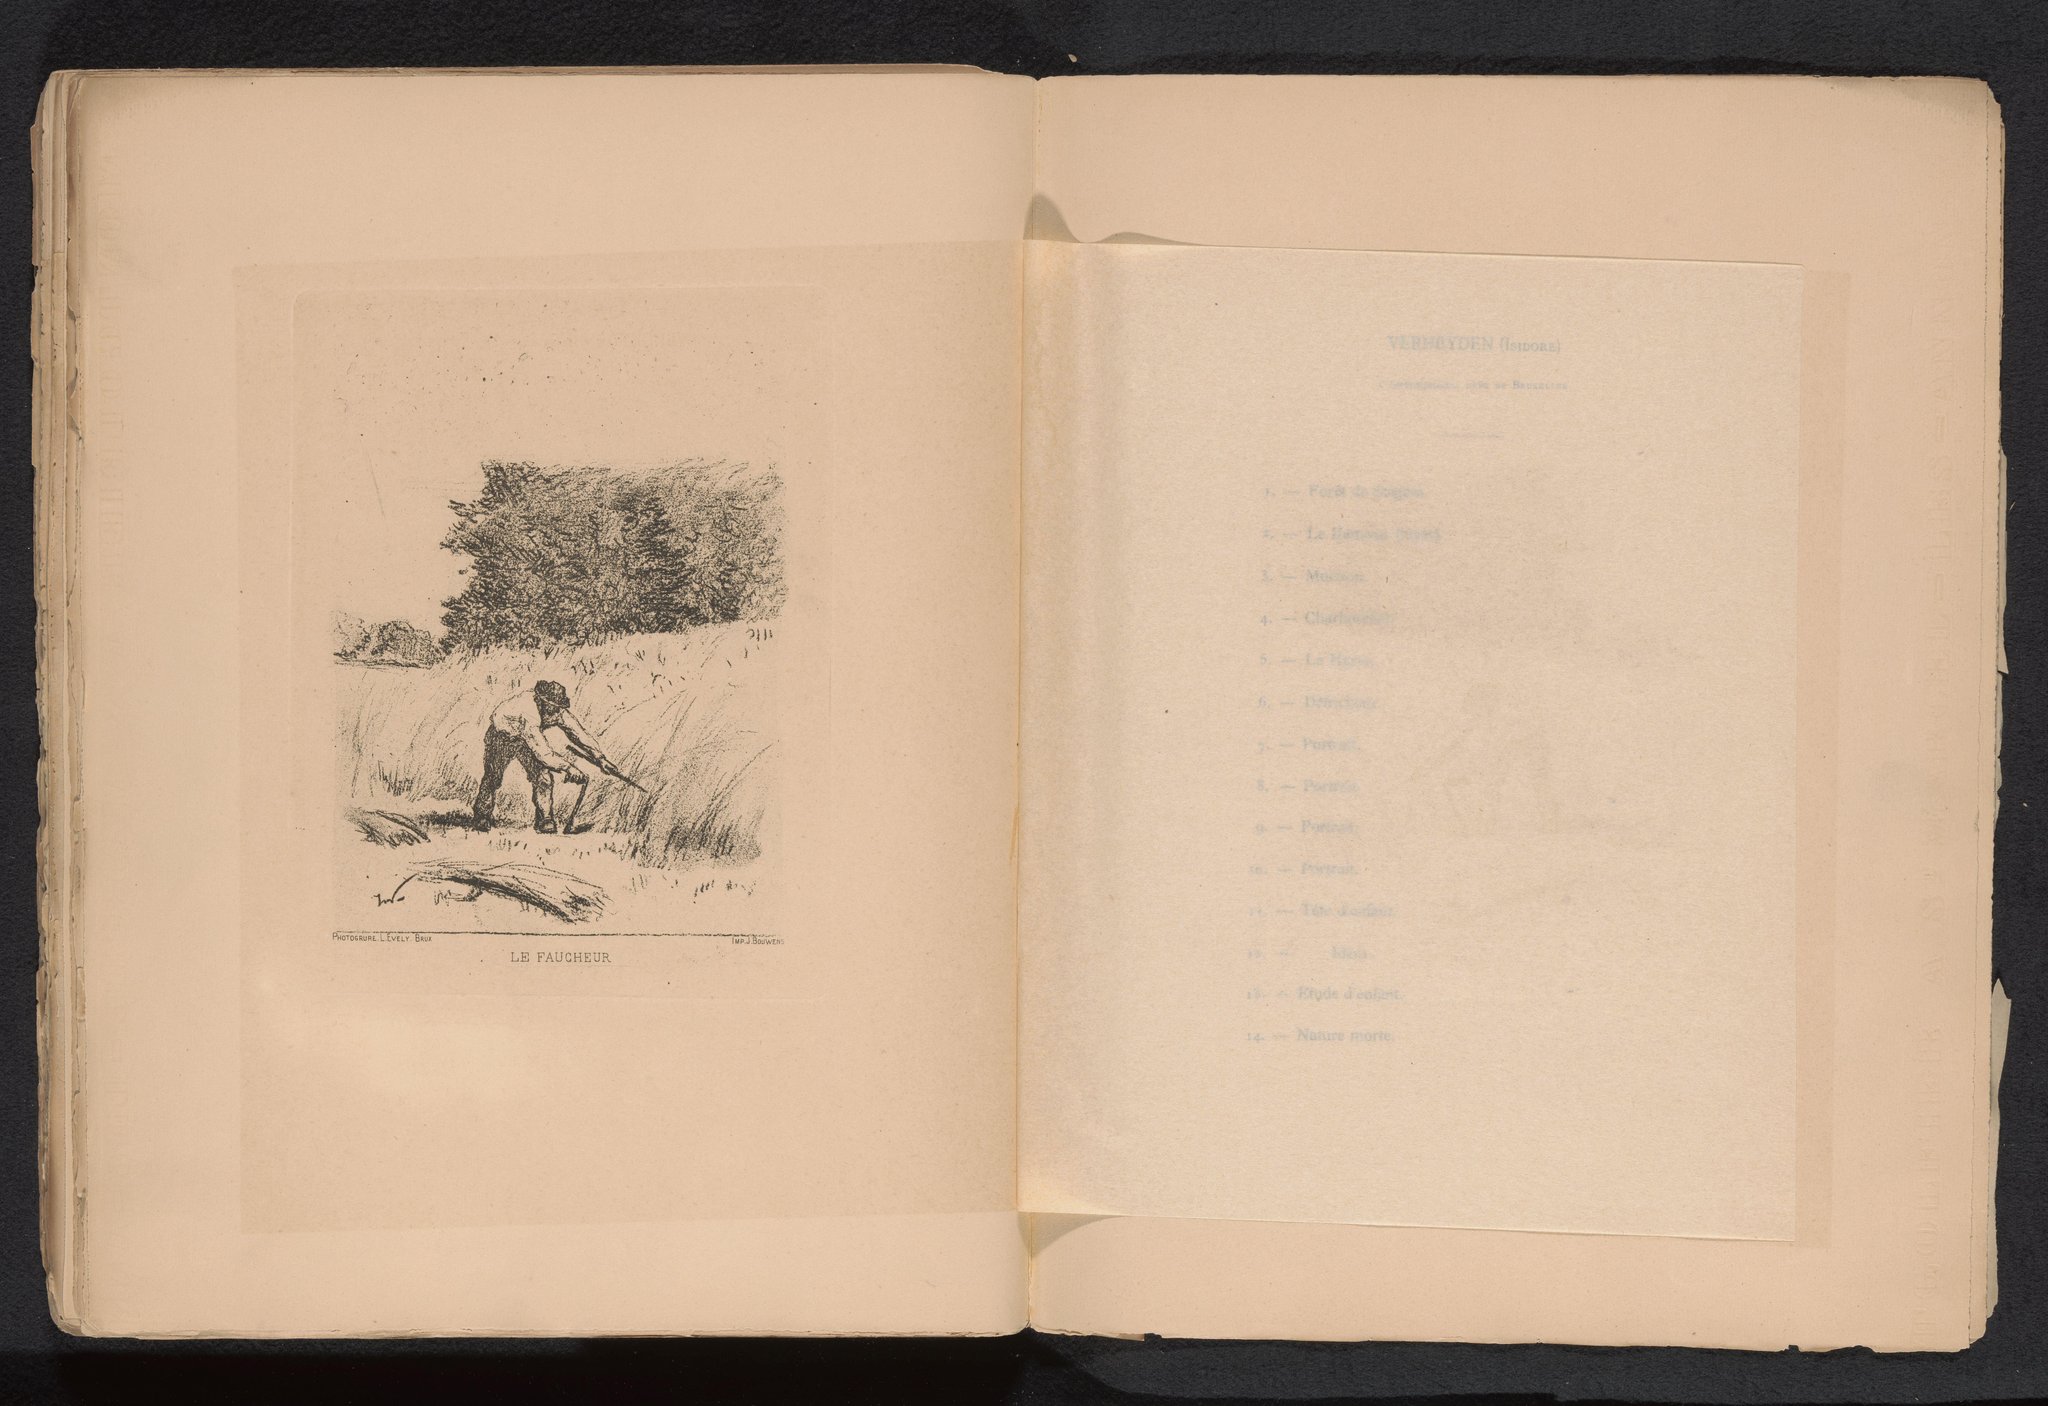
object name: photomechanical print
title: Le Faucheur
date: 1878-1883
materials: paper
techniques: photoaquatint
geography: brussels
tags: reaping, picking, mowing ~ harvest (+ men (labourers))